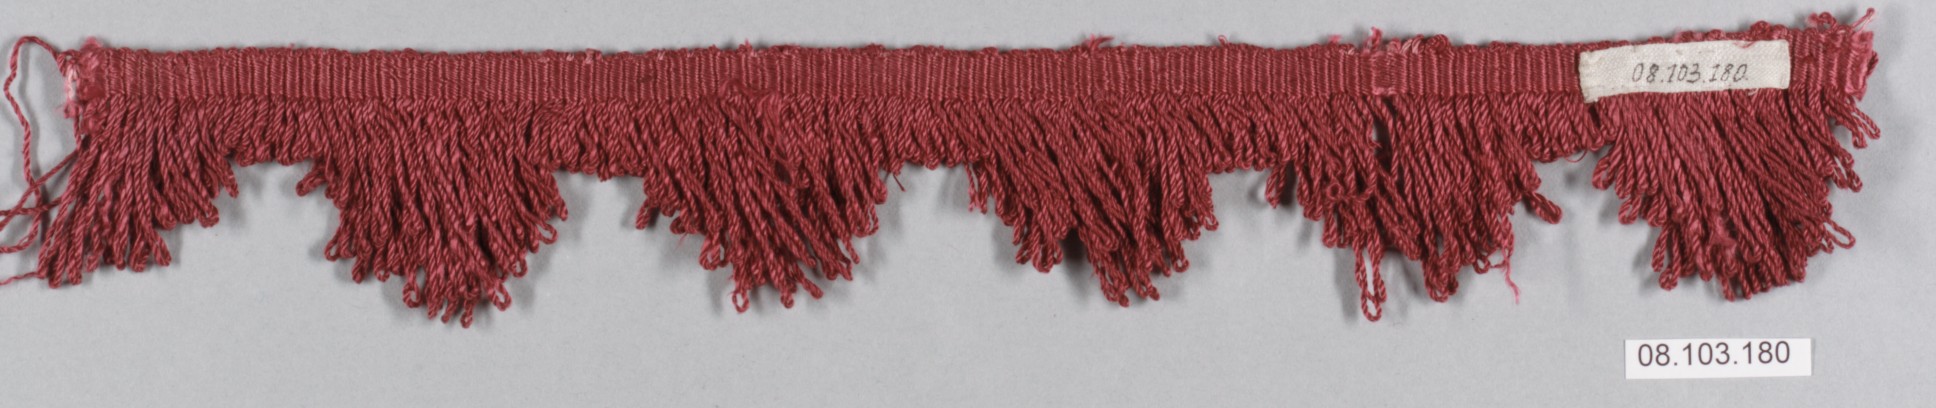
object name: fringe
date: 1701-1900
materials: silk